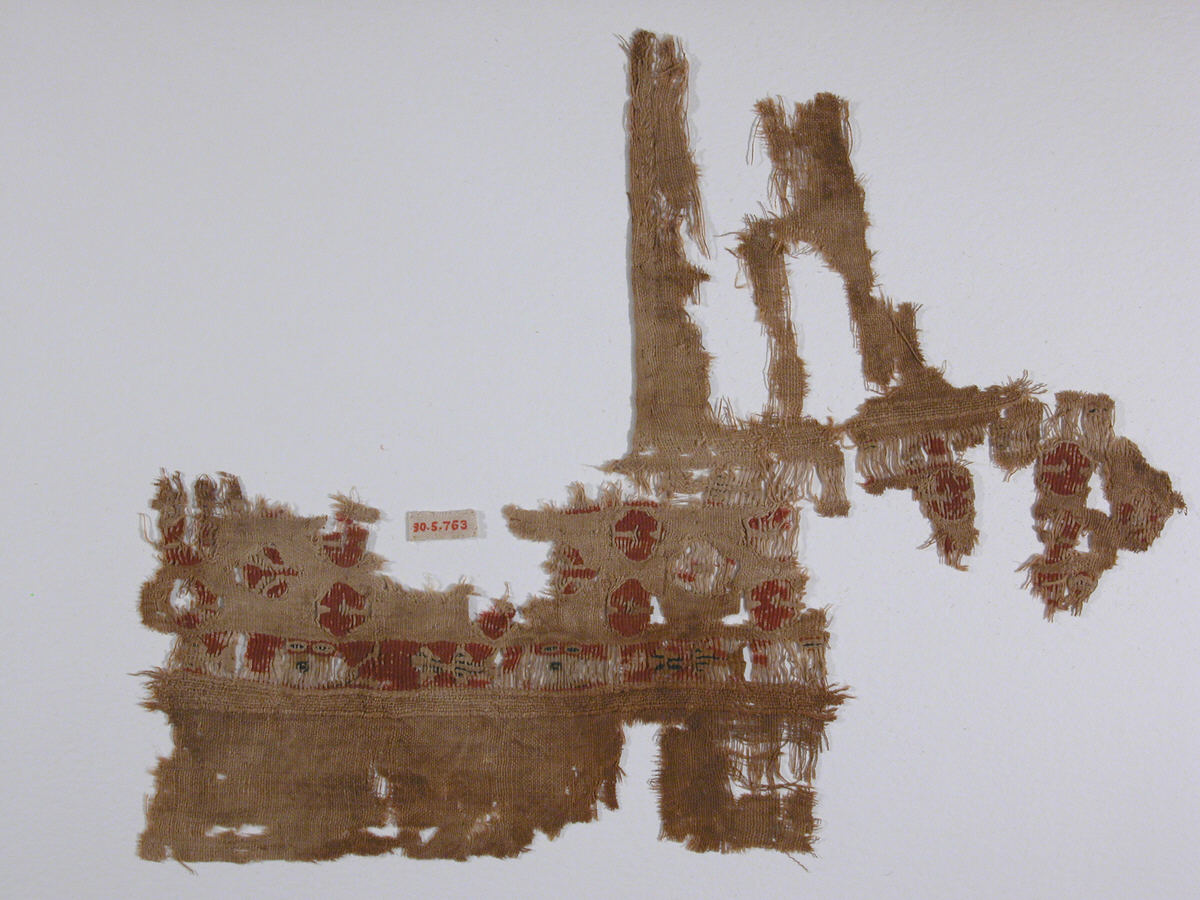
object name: textile fragment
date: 401-500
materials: linen, wool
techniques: weave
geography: egypt